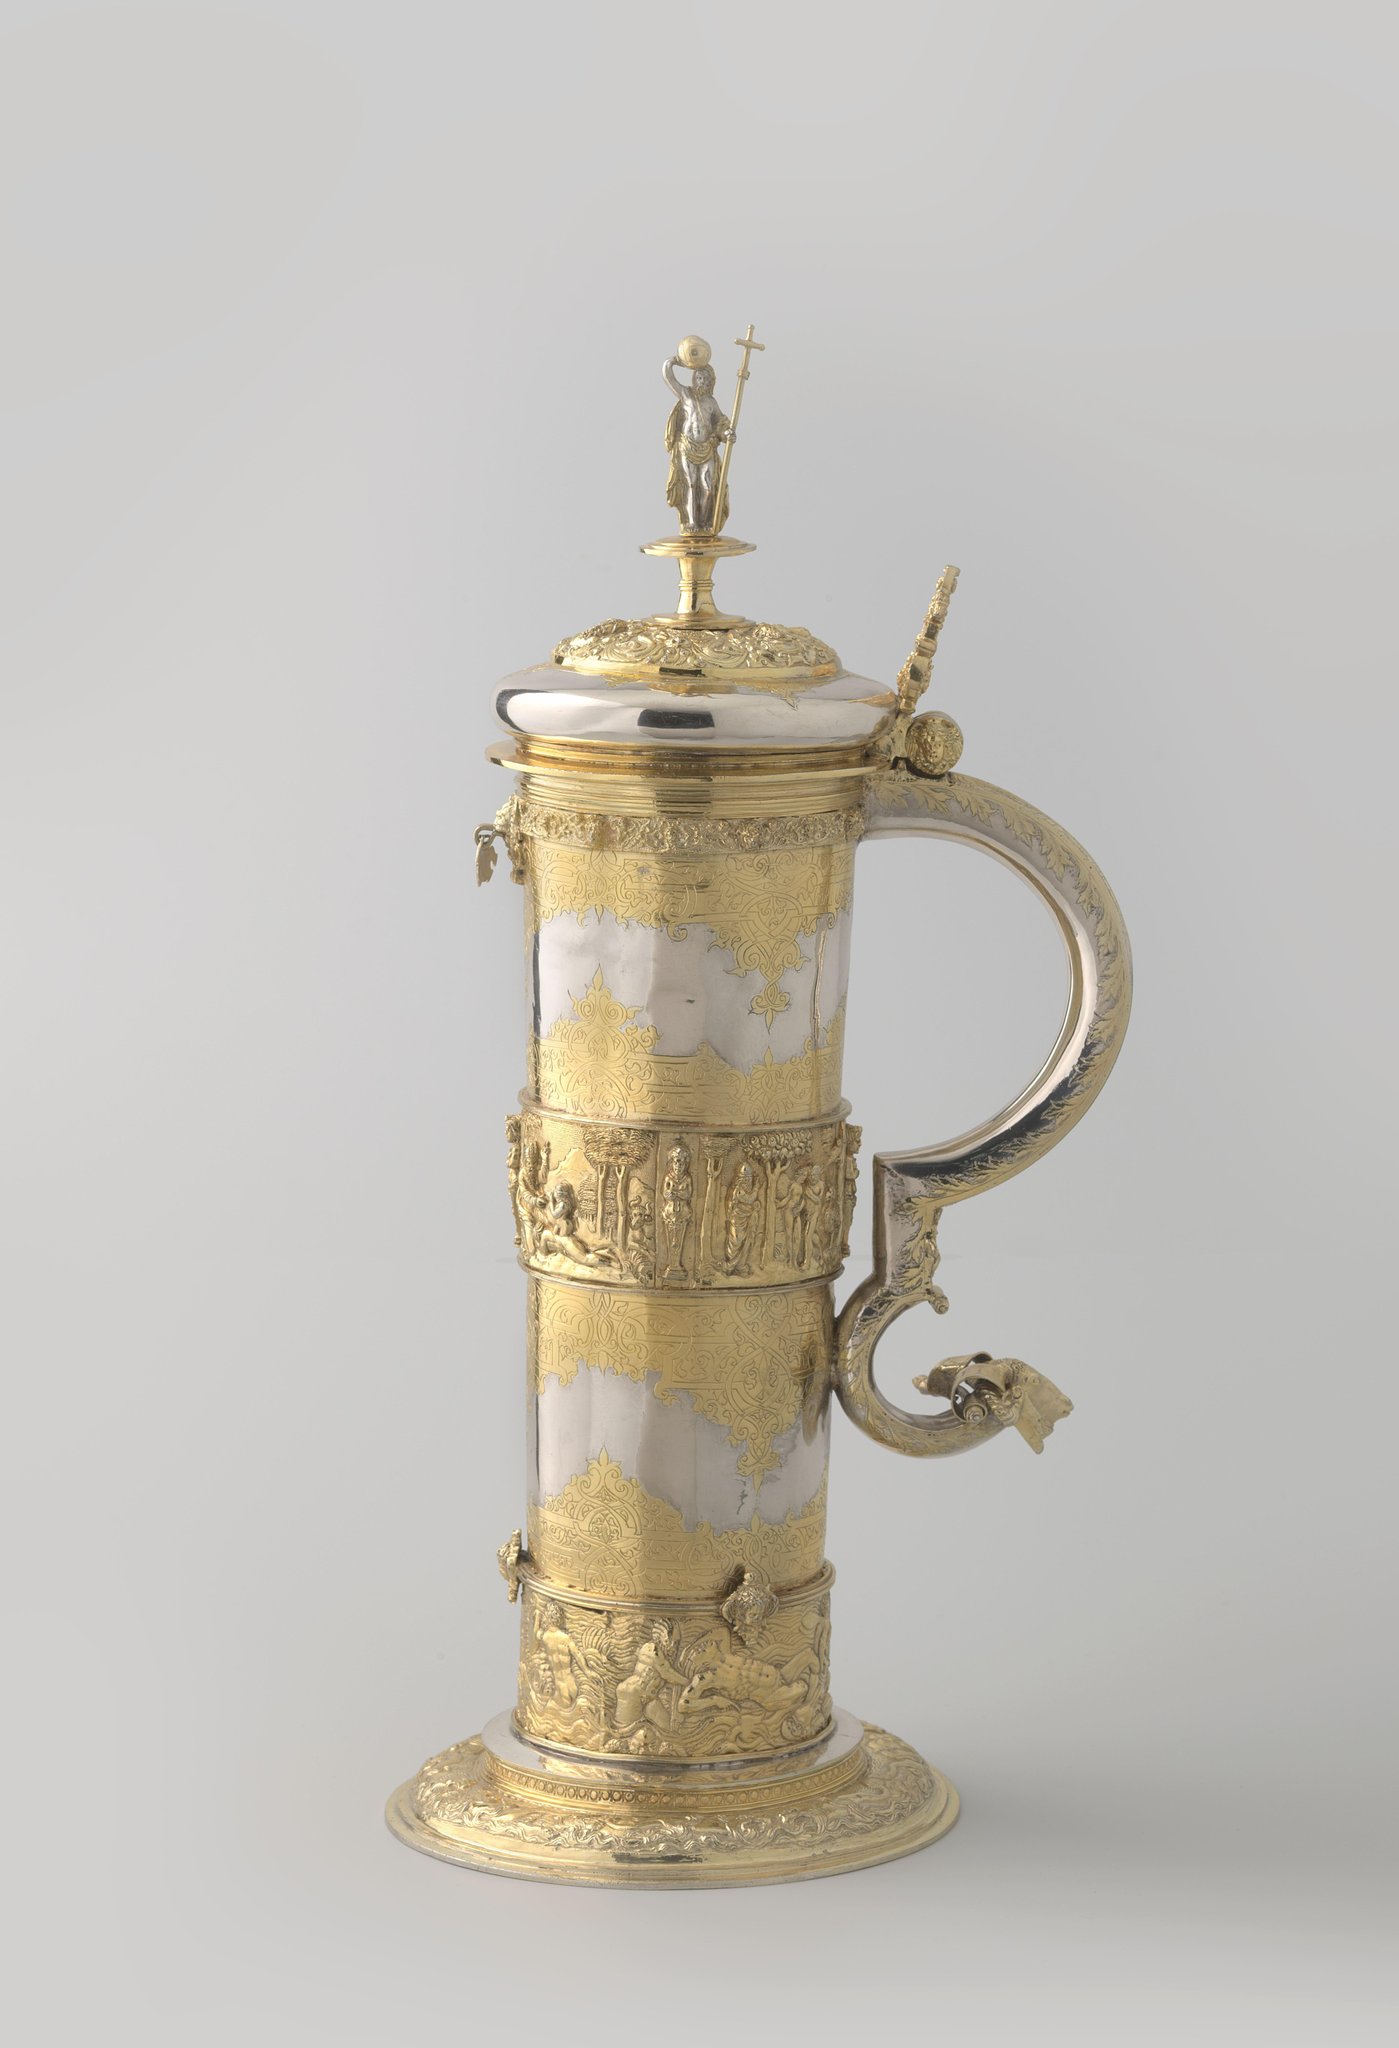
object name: stave tankard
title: Bierpul van gedeeltelijk verguld zilver, cilindervormig op brede, valkke voet. Oor eindigt in ramskop. Om het midden gegoten fries met zondeval en verdrijving uit het Paradijs. Knop op deksel in vorm van Christus met wereldbol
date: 1569-1616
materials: silver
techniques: gilding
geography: riga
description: Bierpul. Gedeeltelijk verguld zilver. Riga, ca. 1580-1600, door Lambert Goldenstätt.